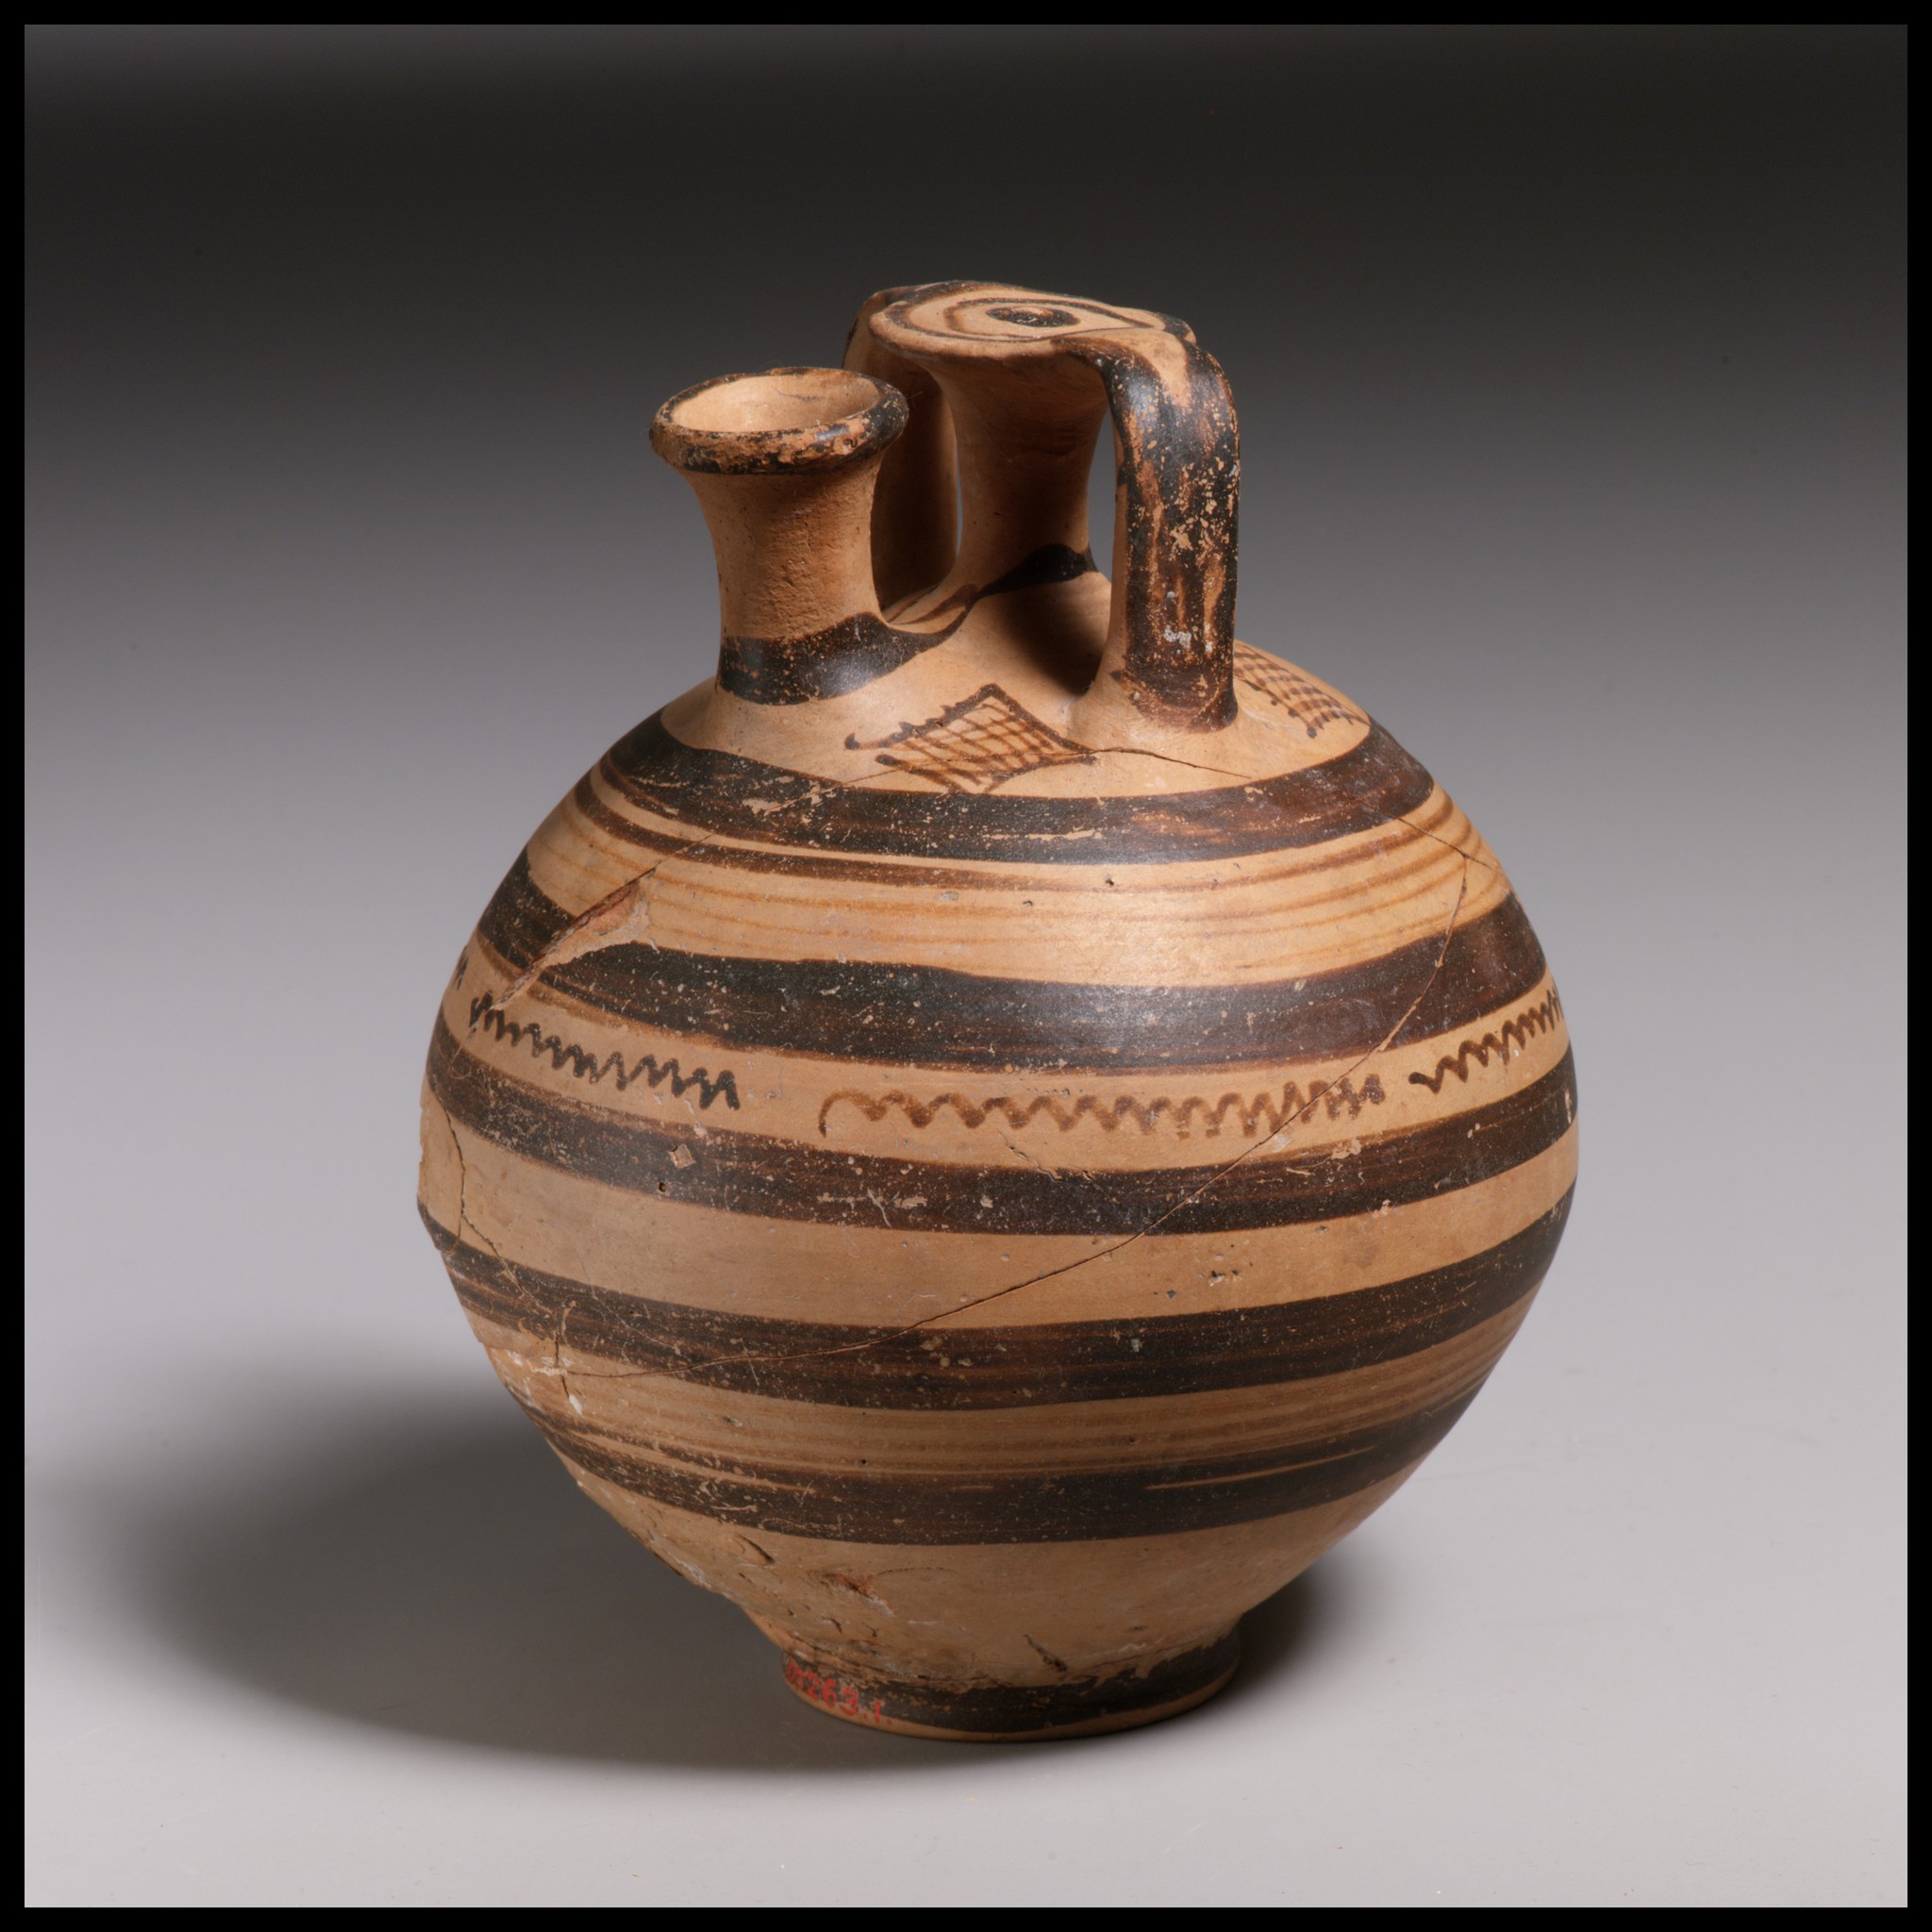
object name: false necked jar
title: Terracotta stirrup jar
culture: mycenaean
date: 1300-1200 BCE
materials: terracotta